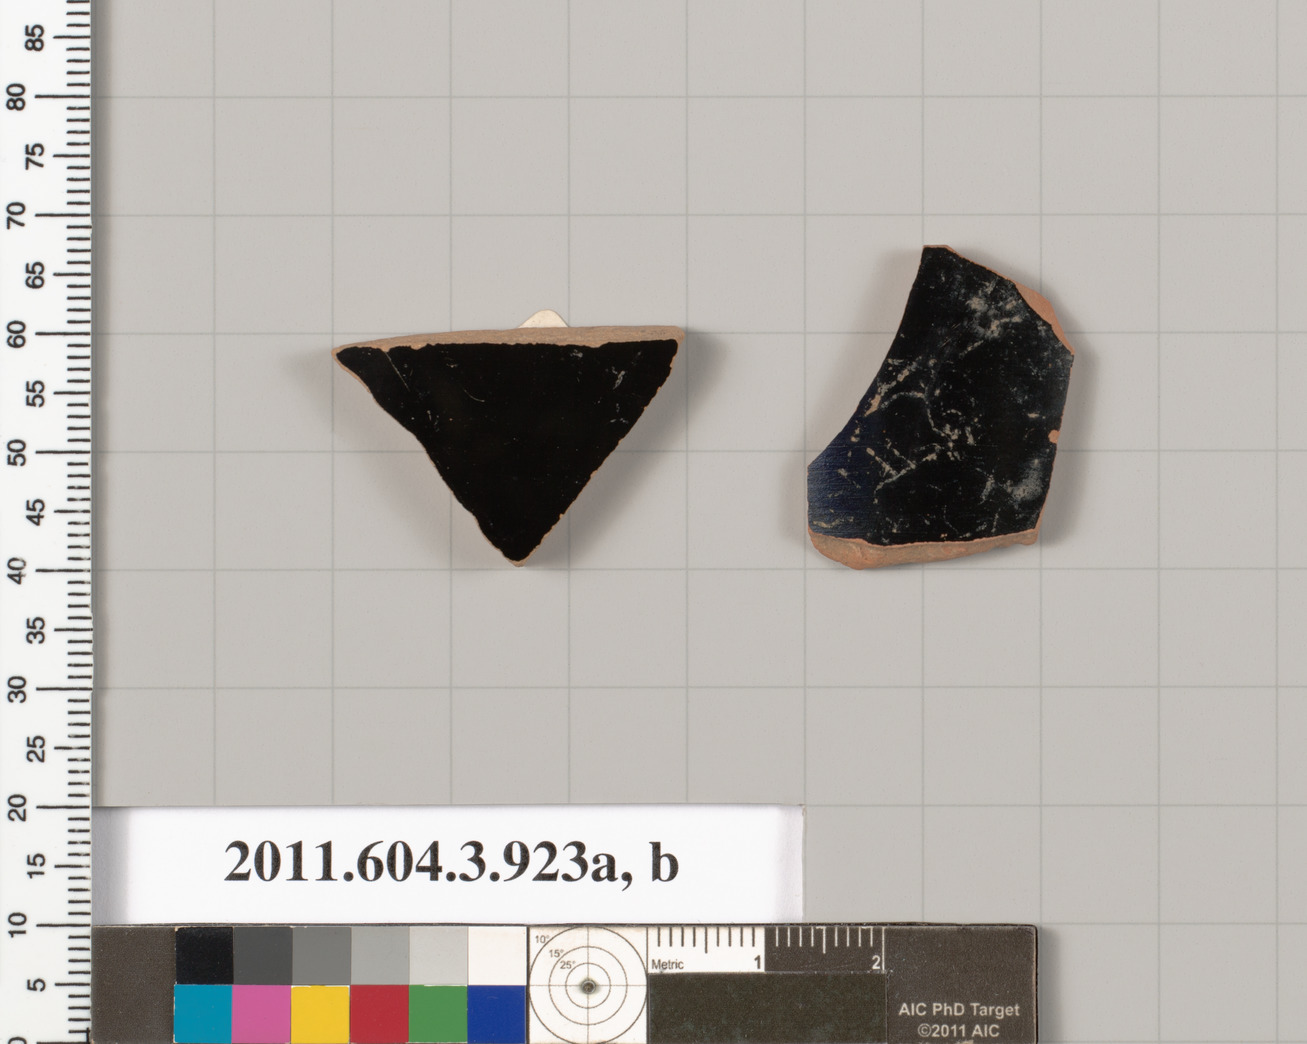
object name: lekythos fragment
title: Terracotta fragments of lekythoi (oil flasks)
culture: greek, attic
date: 600-401 BCE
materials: terracotta